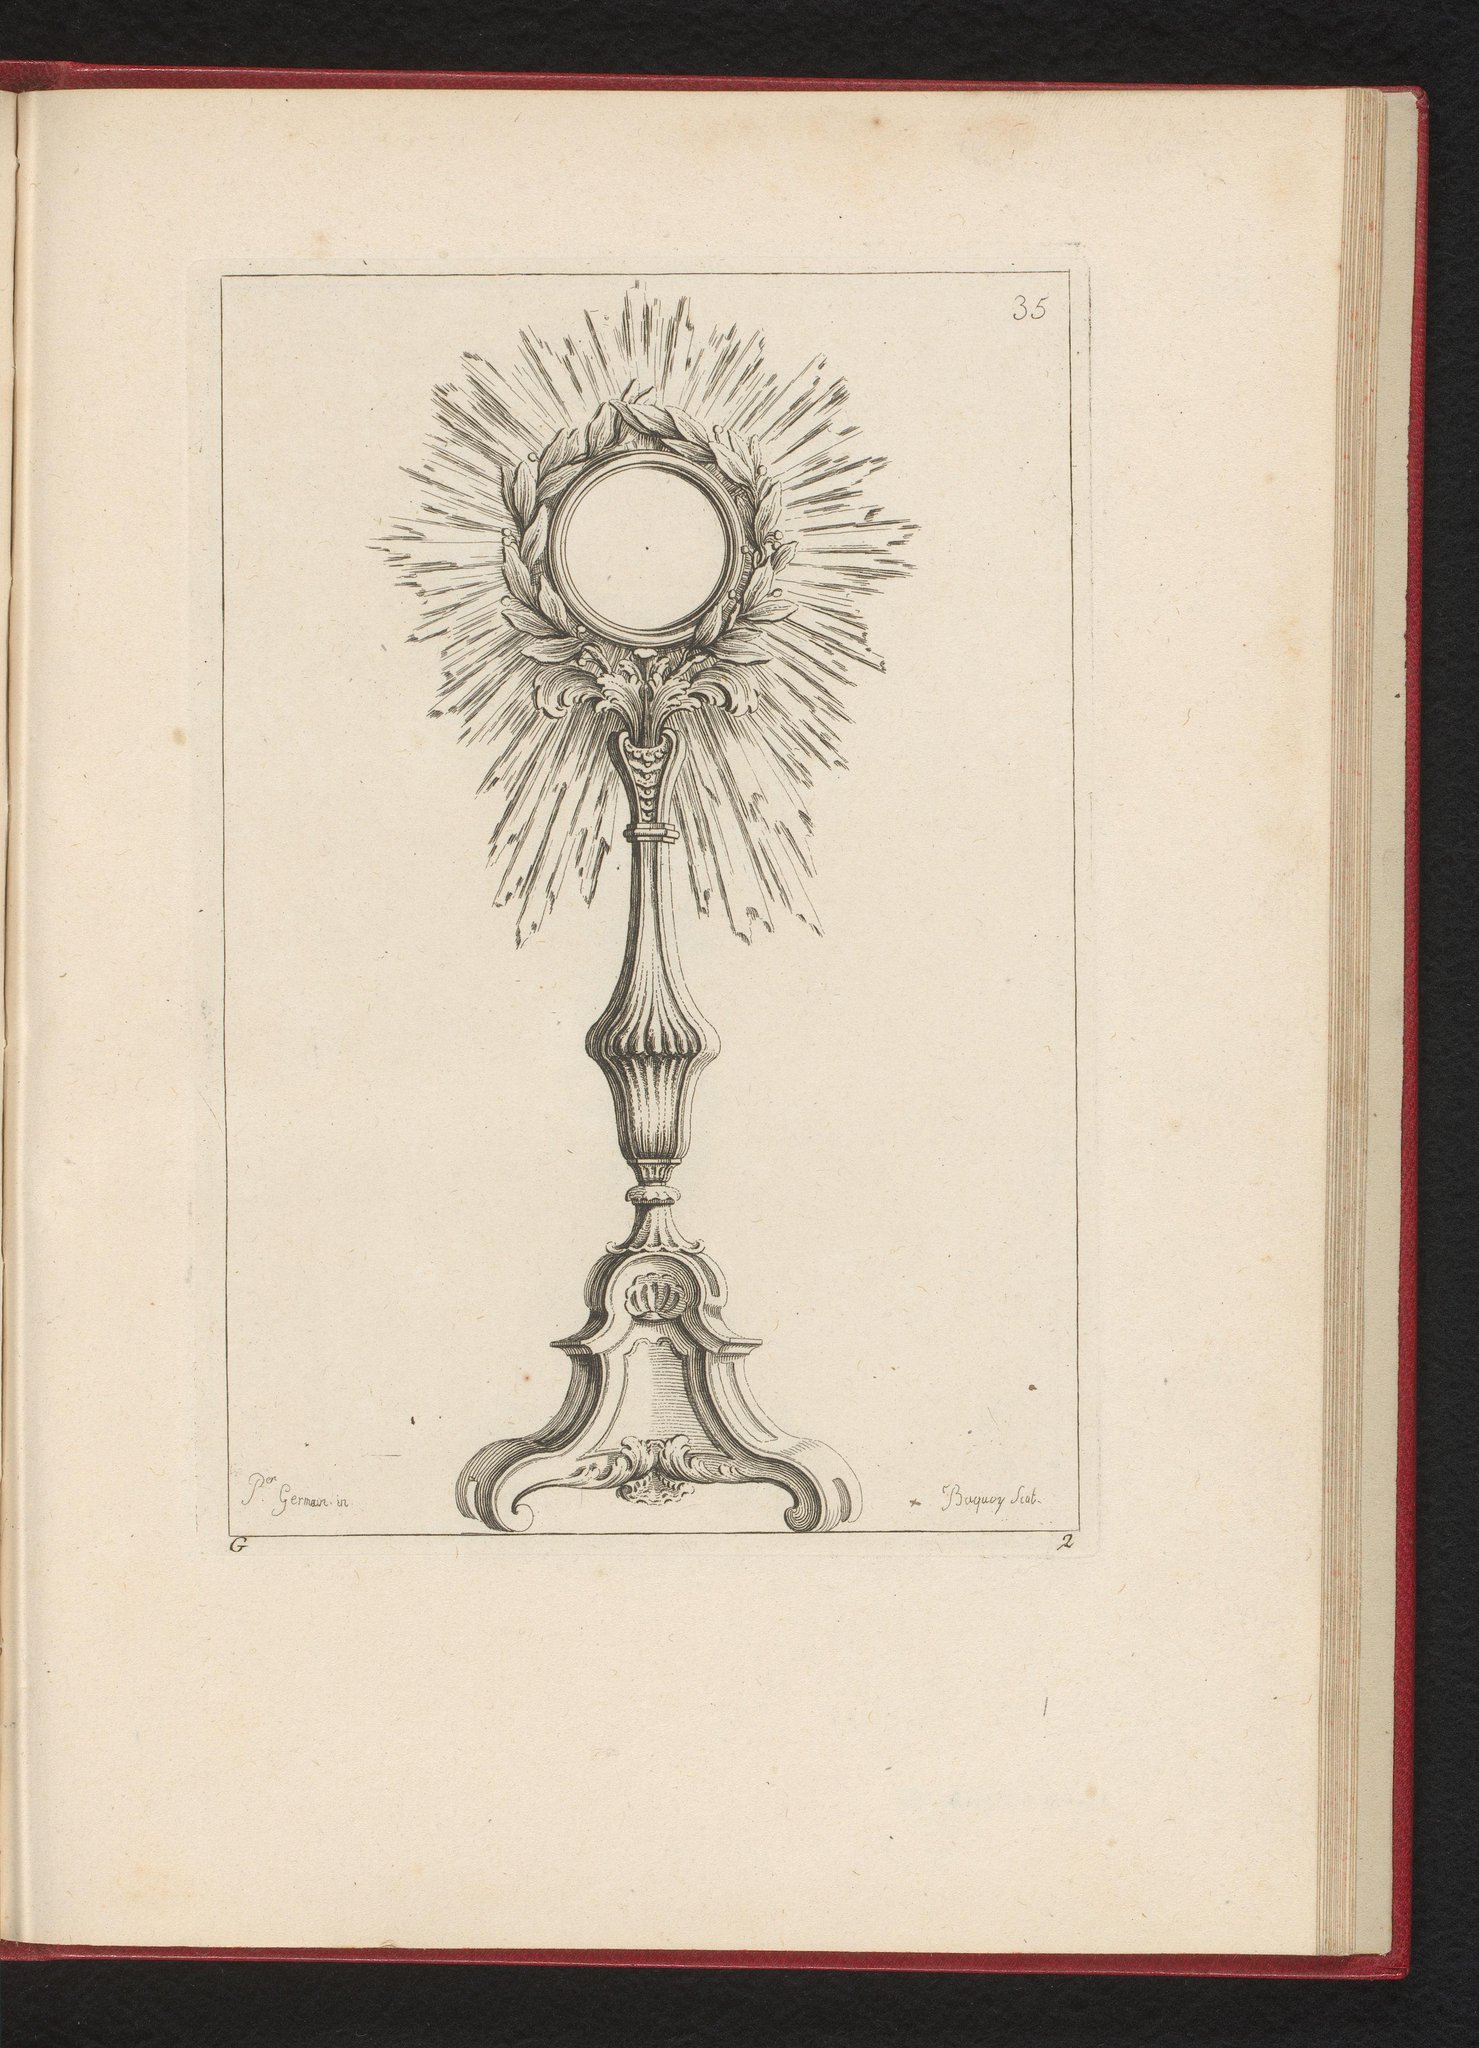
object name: album leaf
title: Ontwerp voor een zonnemonstrans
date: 1748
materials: paper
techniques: etching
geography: paris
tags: ostensorium, monstrance, jeweller, goldsmith, silversmith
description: Deze prent maakt deel uit van een album.